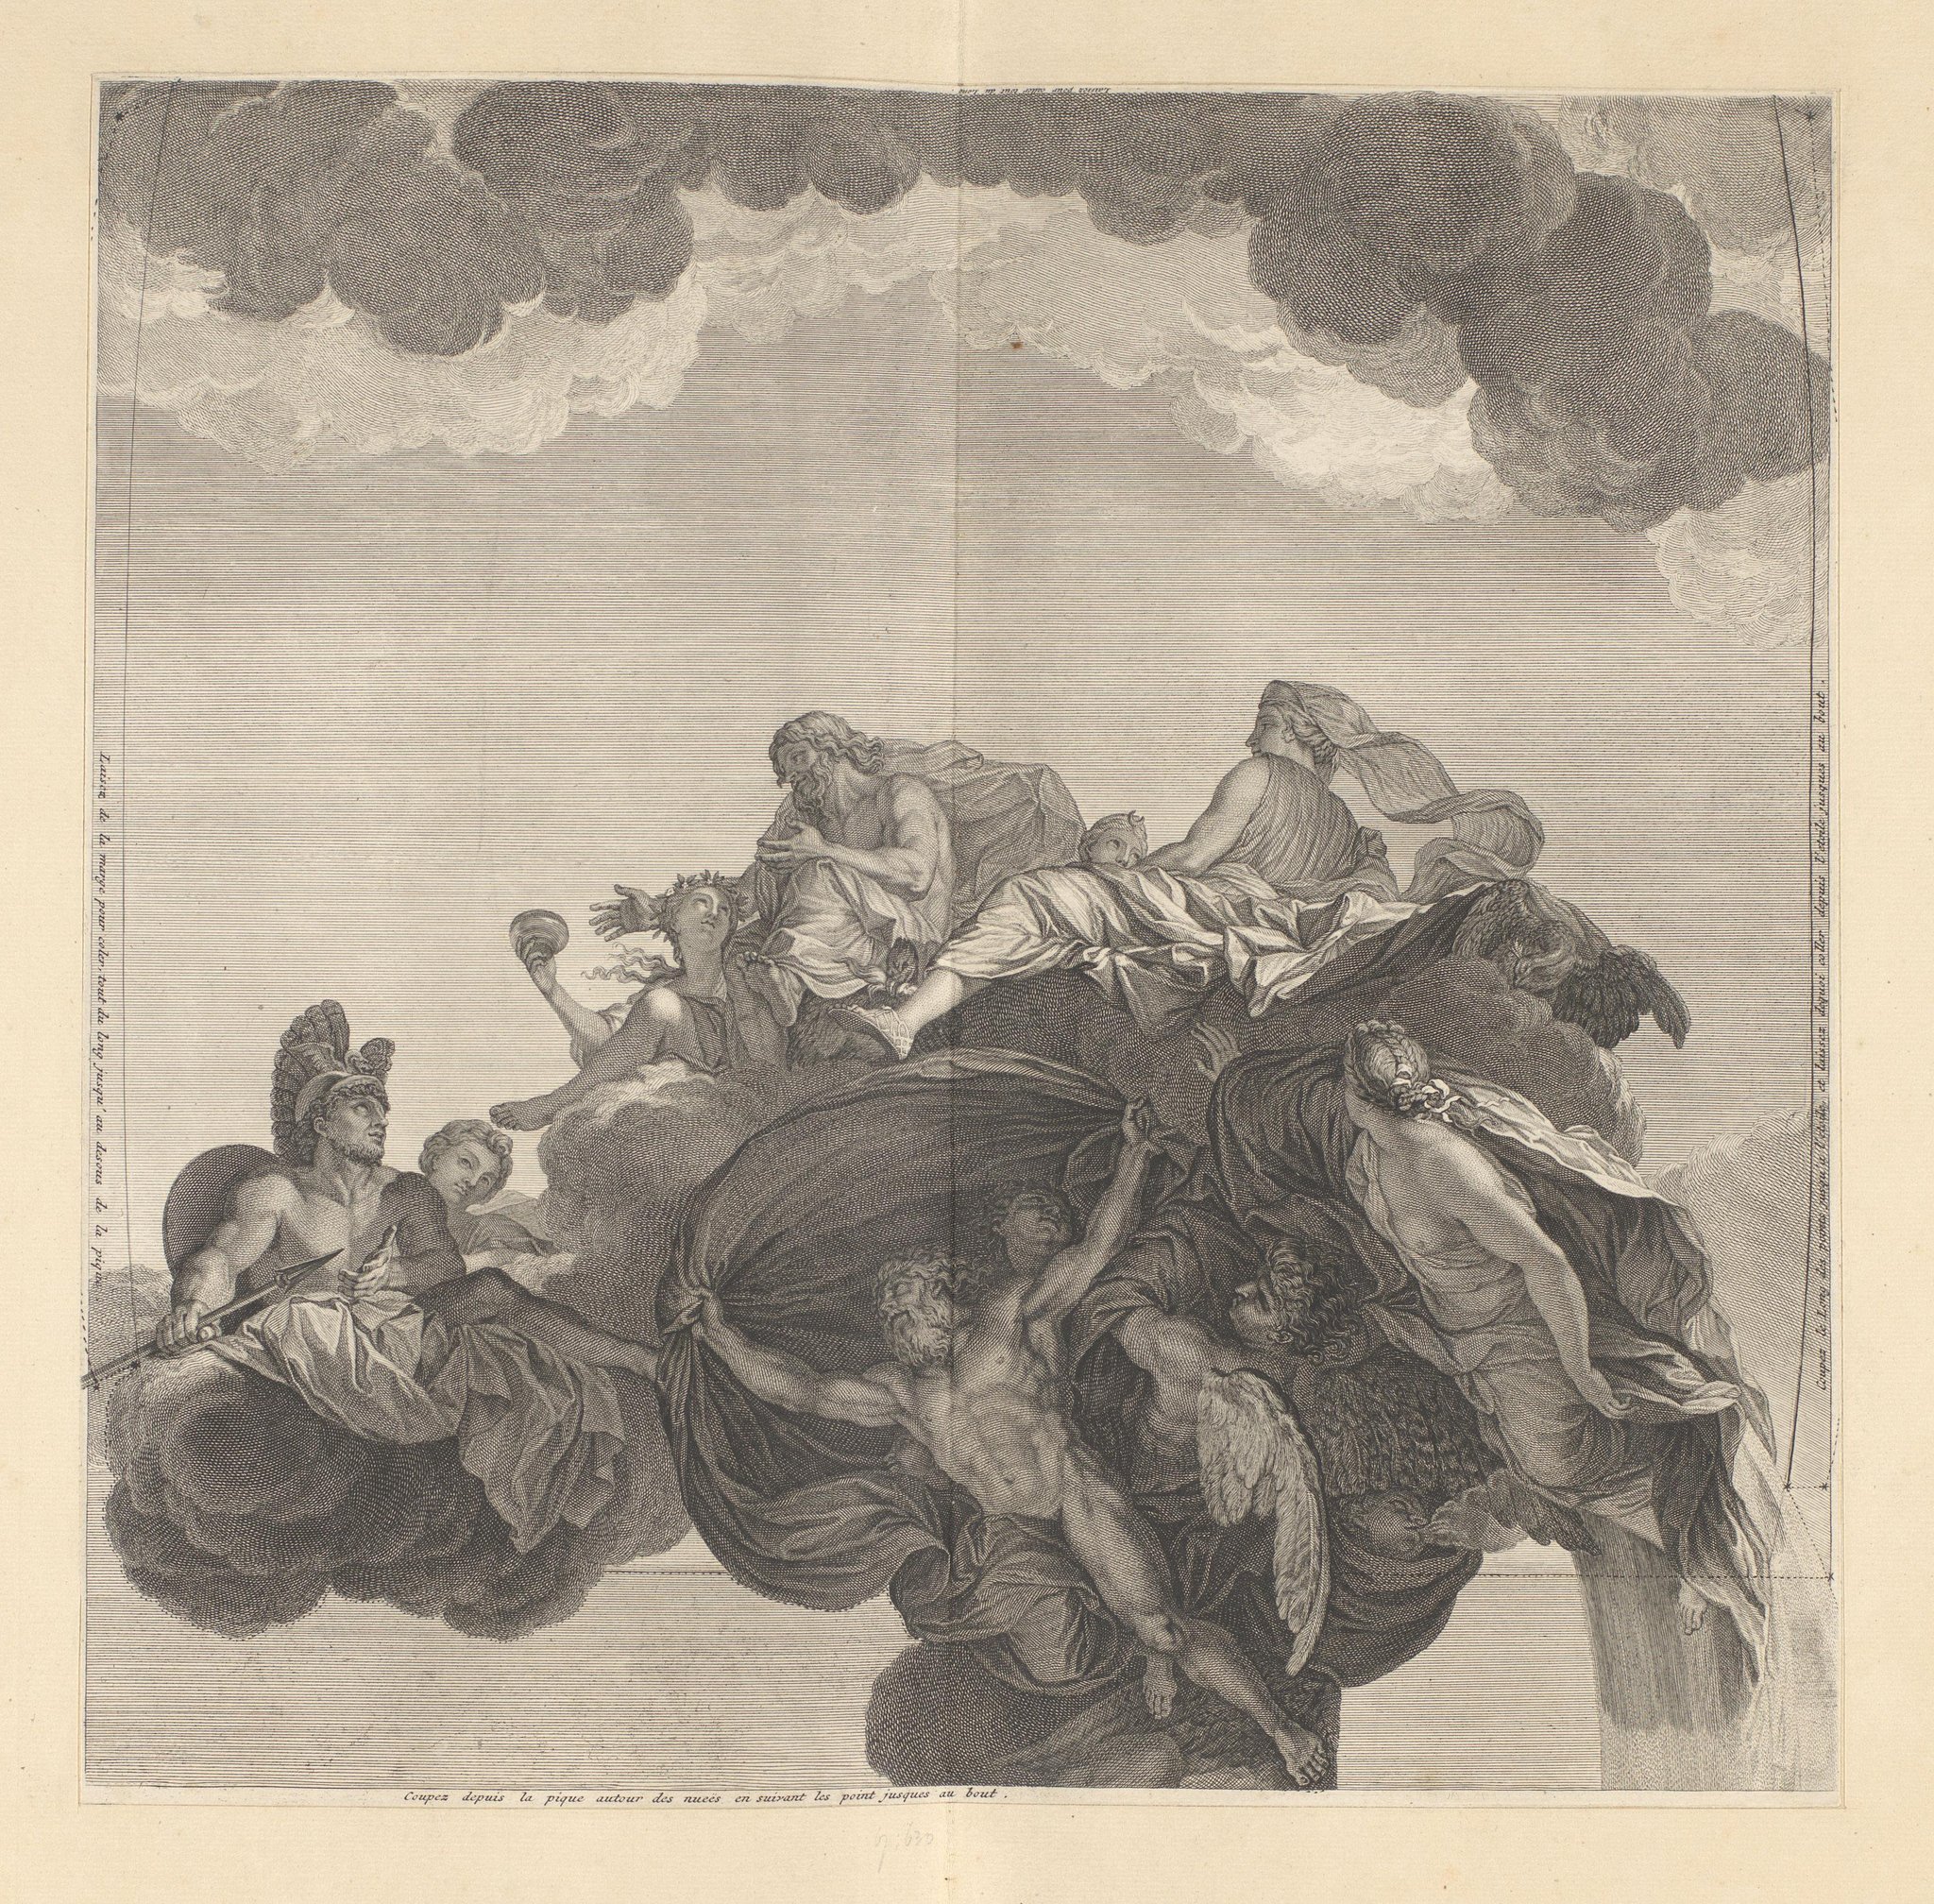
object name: album leaf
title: La galerie de monsr. le president Lambert representant l'Apotheose d'Hercule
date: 1710-1720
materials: paper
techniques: engraving, etching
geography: amsterdam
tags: (decorated) ceiling, apotheosis of hercules: he is borne to heaven in a four-horse chariot and reconciled with juno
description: Jupiter, Juno en de andere goden ontvangen Hercules. Jupiter presenteert zijn dochter Hebe aan Hercules. Langs de randen instructies voor het monteren van de prent aan andere prenten. Prent maakt deel uit van een serie prenten, die samen het geschilderde plafond met de Apotheose van Hercules in het Hôtel Lambert te Parijs voorstellen. Deze prent maakt deel uit van een album.